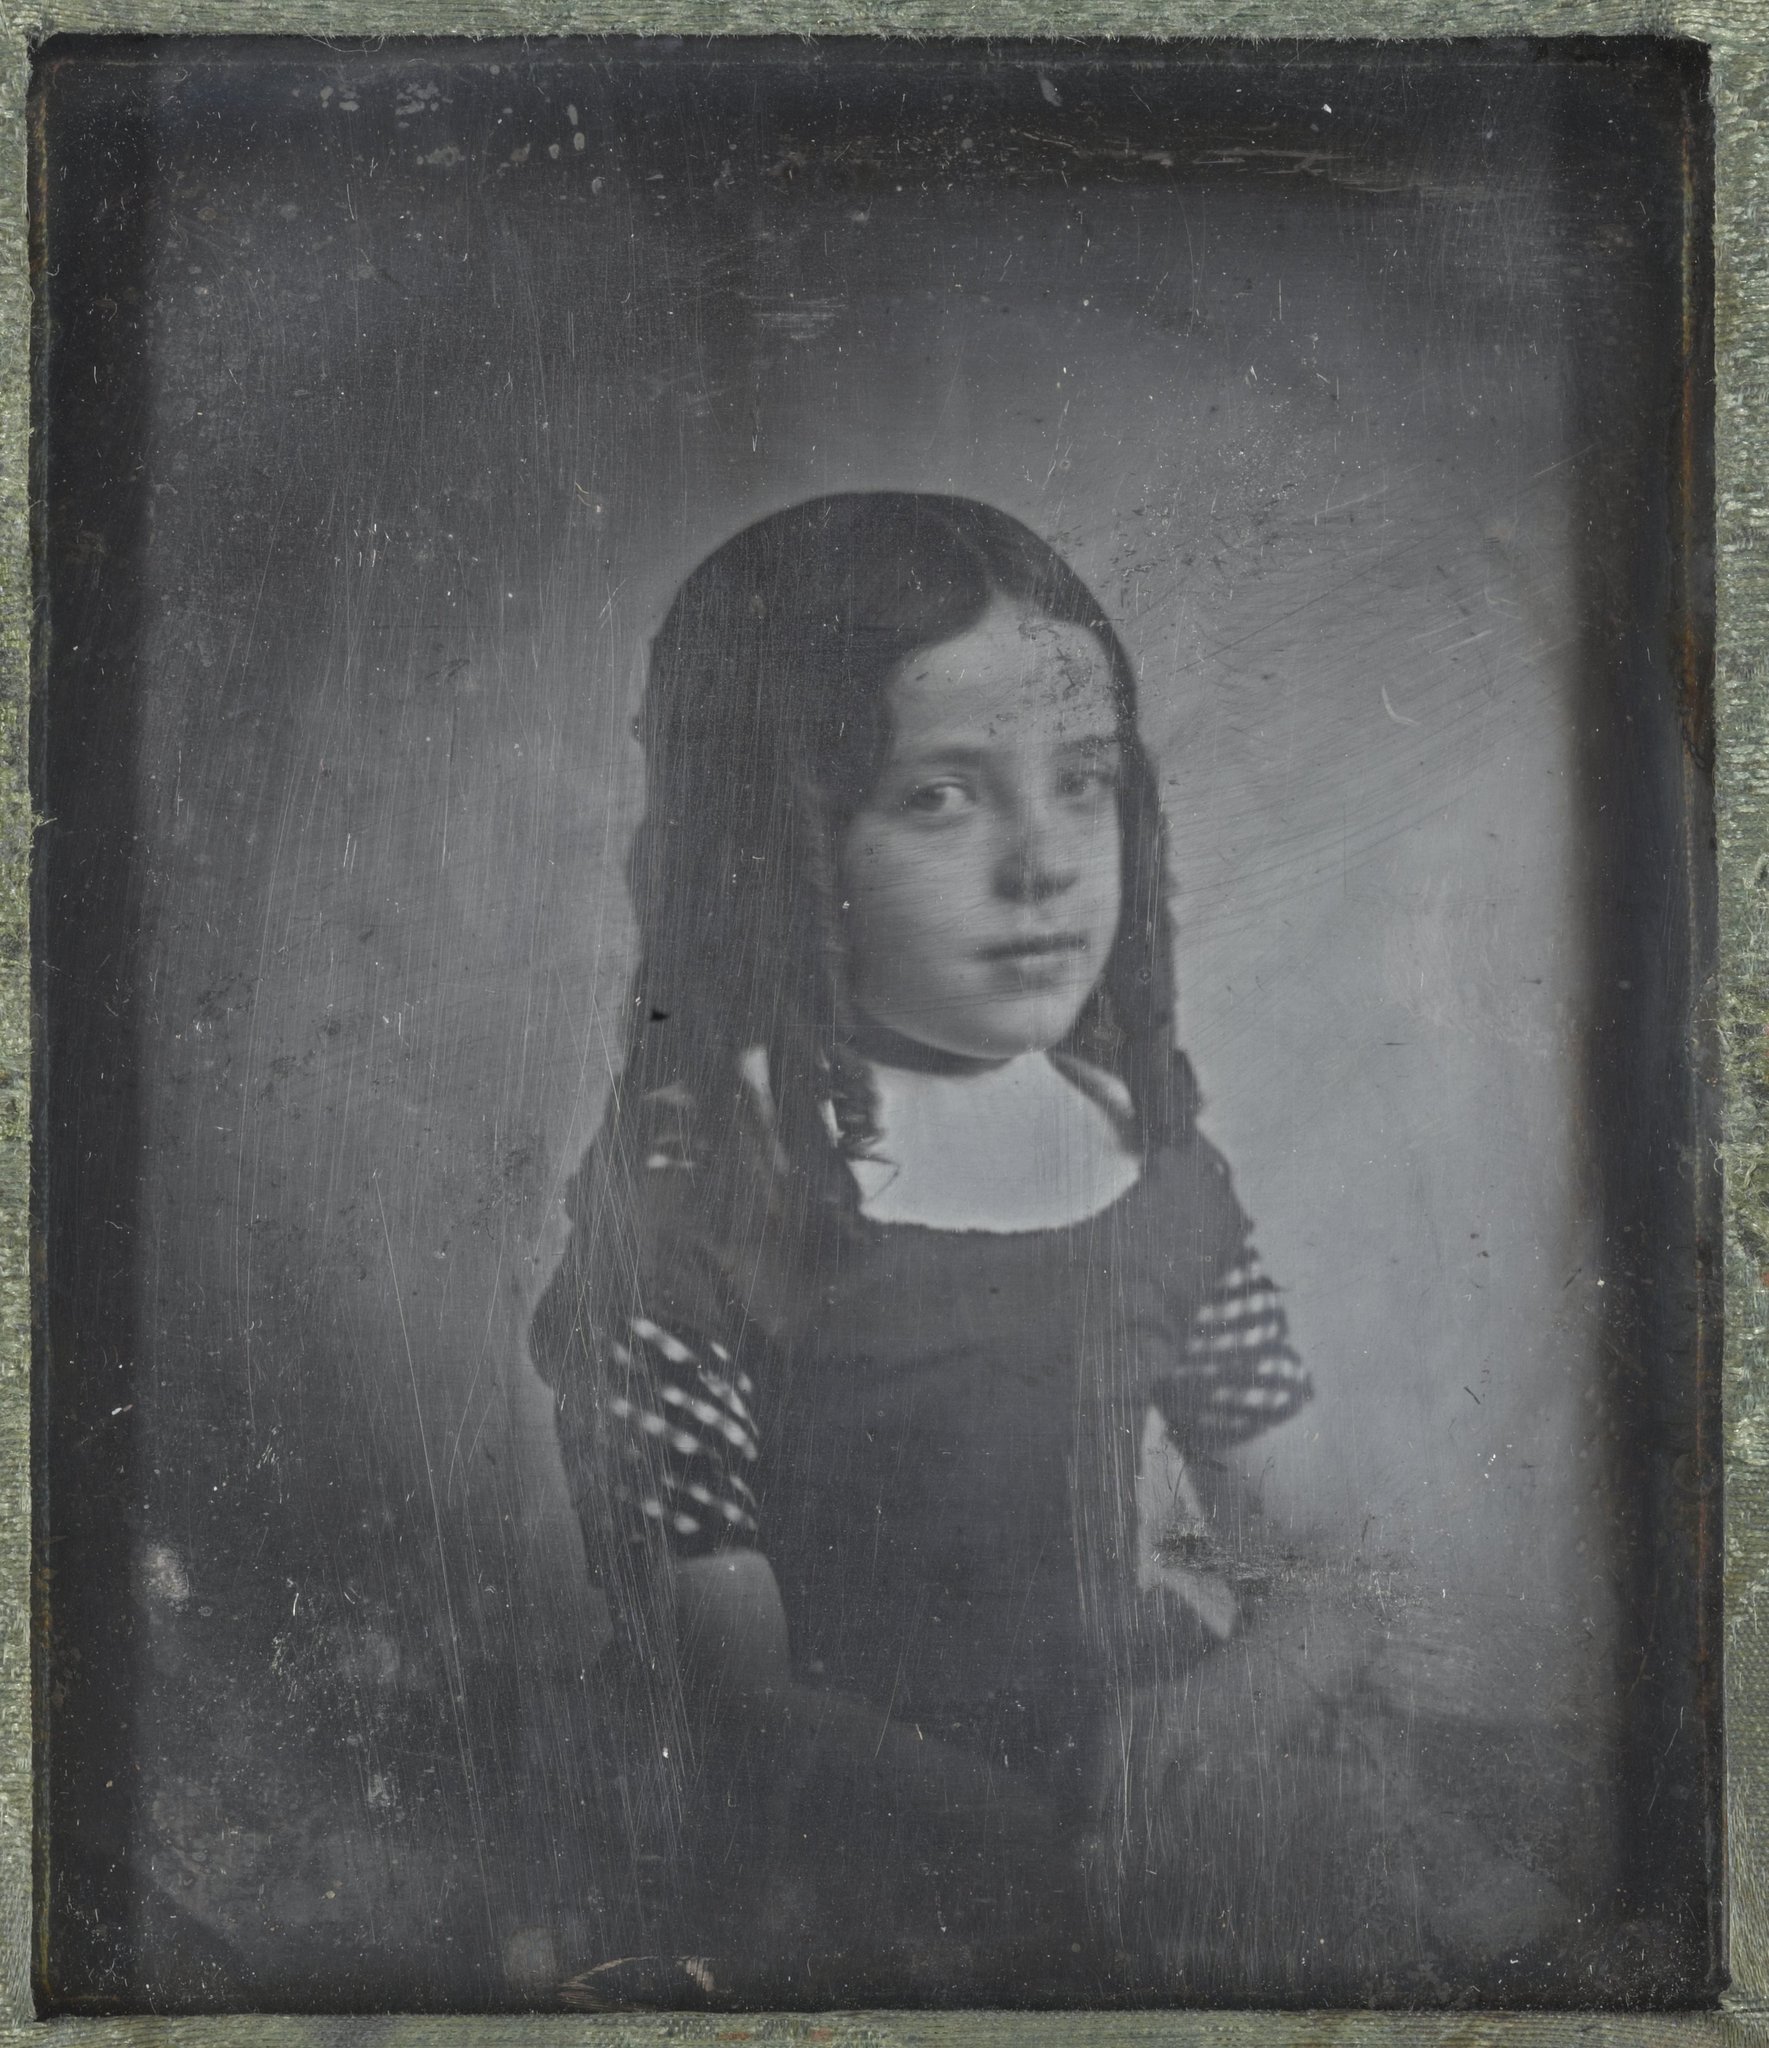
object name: photograph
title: Portrait of the Photographer’s Daughter Charlotte Asser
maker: eduard isaac asser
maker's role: amateurfotograaf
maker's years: 1809-1894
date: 1842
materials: copper, glass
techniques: daguerreotype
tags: brussels, netherlands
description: Born into a prosperous family of Amsterdam lawyers, Asser pursued not only a legal career, but was also an amateur painter and pioneering photographer. He portrayed his friends and family, including his second daughter, Charlotte. This is one of the earliest surviving Dutch photographs. It was made c. 1842, not long after Asser had begun to experiment with the medium.